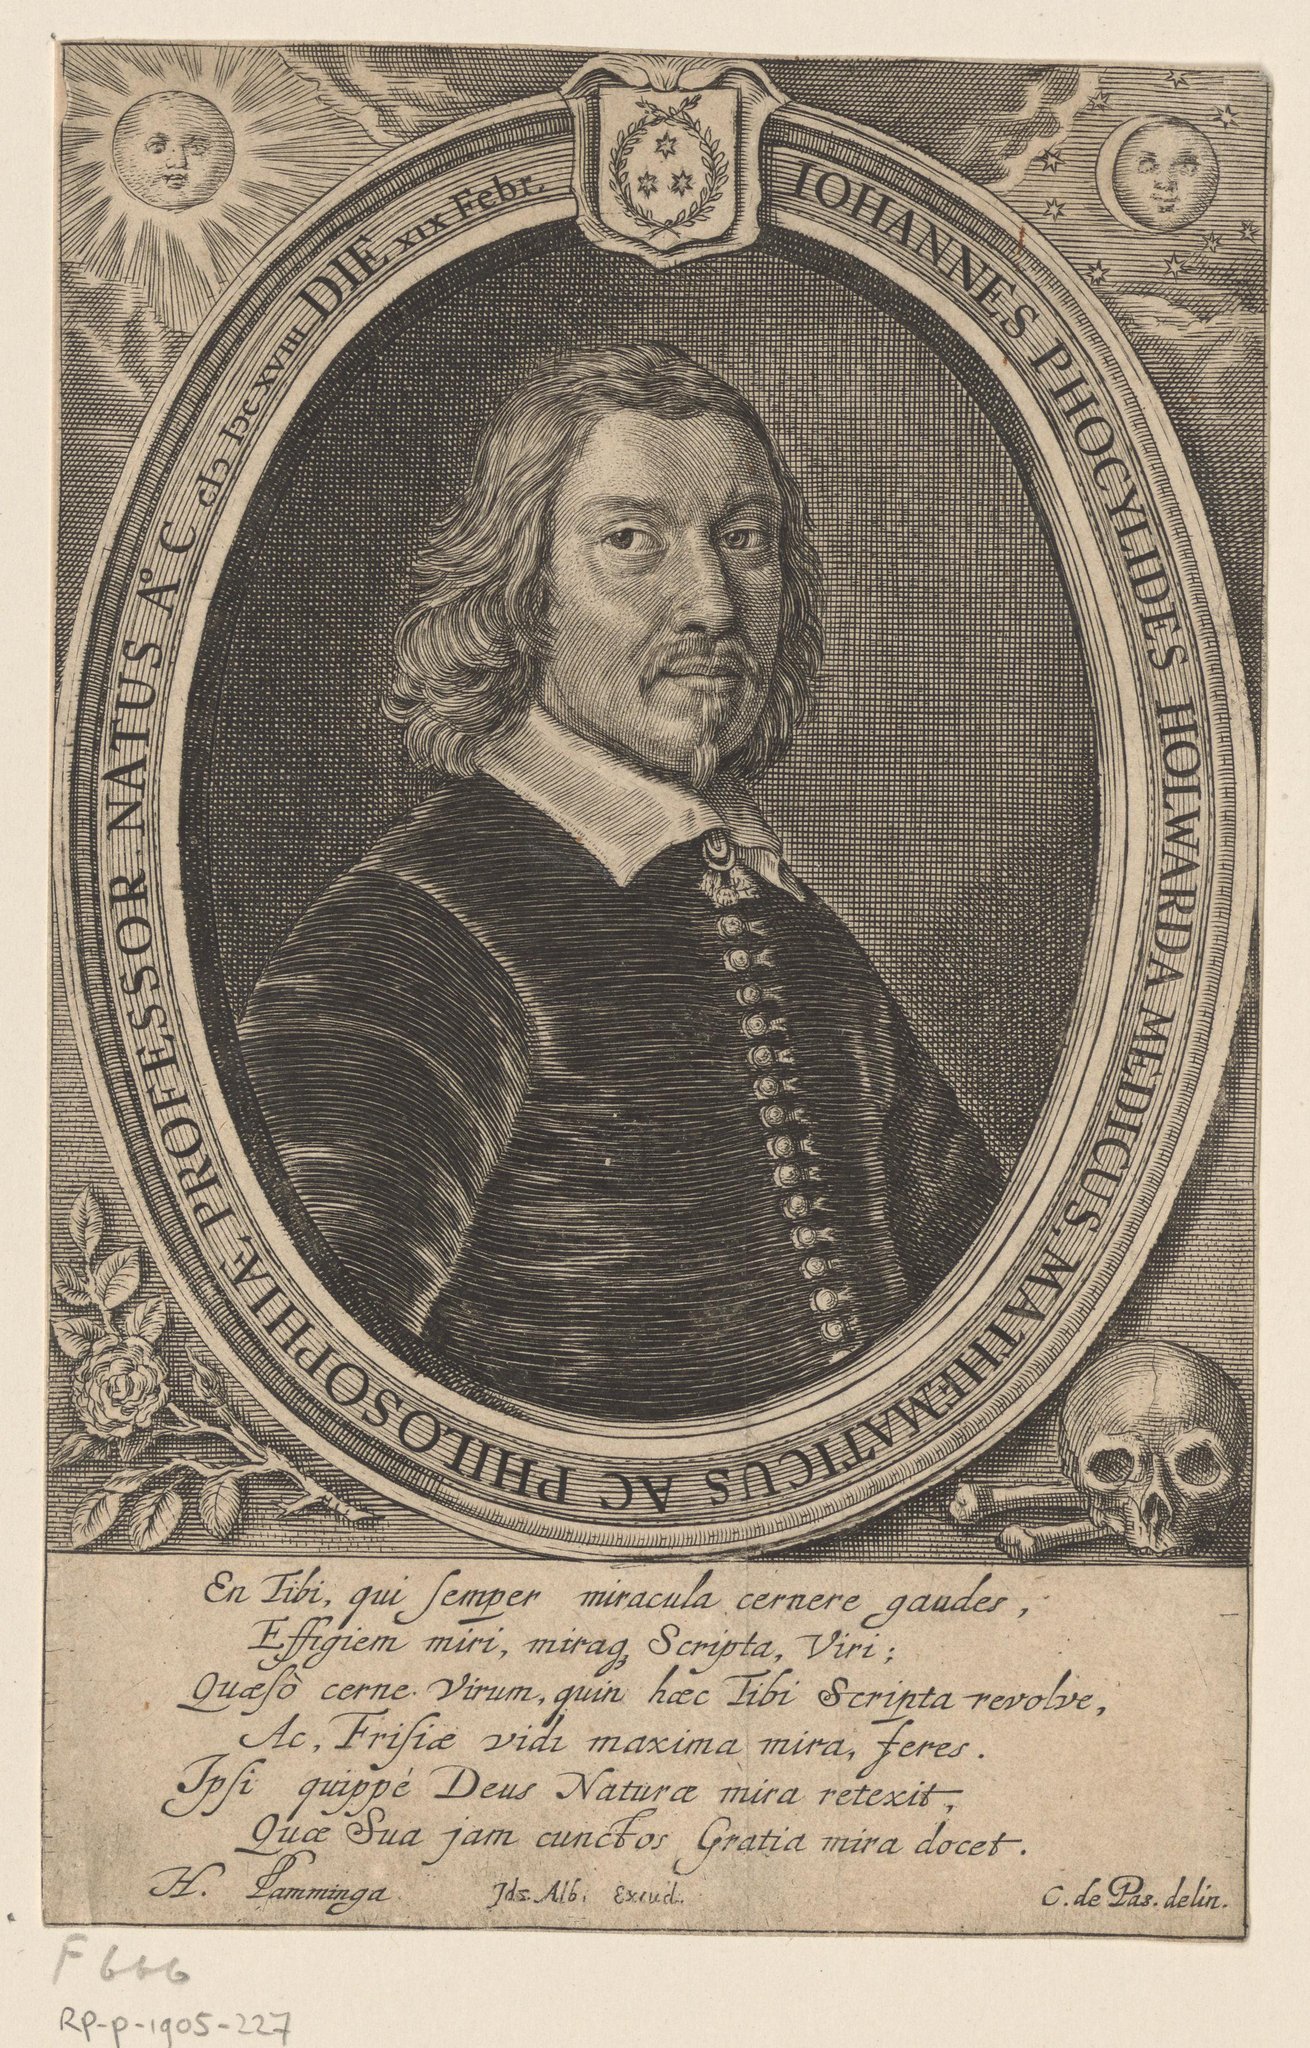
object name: print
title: Portret van Johannes Phocylides Holwarda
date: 1652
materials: paper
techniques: engraving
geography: amsterdam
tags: historical persons, 'vanitas' symbols, creation of sun, moon and stars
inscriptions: mark: Lugt 1337, collector's mark: Lugt 2228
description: Bovenaan de omlijsting het wapenschild van de geportretteerde. In de hoeken de zon, maan, sterren en symbolen van vergankelijkheid. In de marge een zesregelig lofdicht in het Latijn.